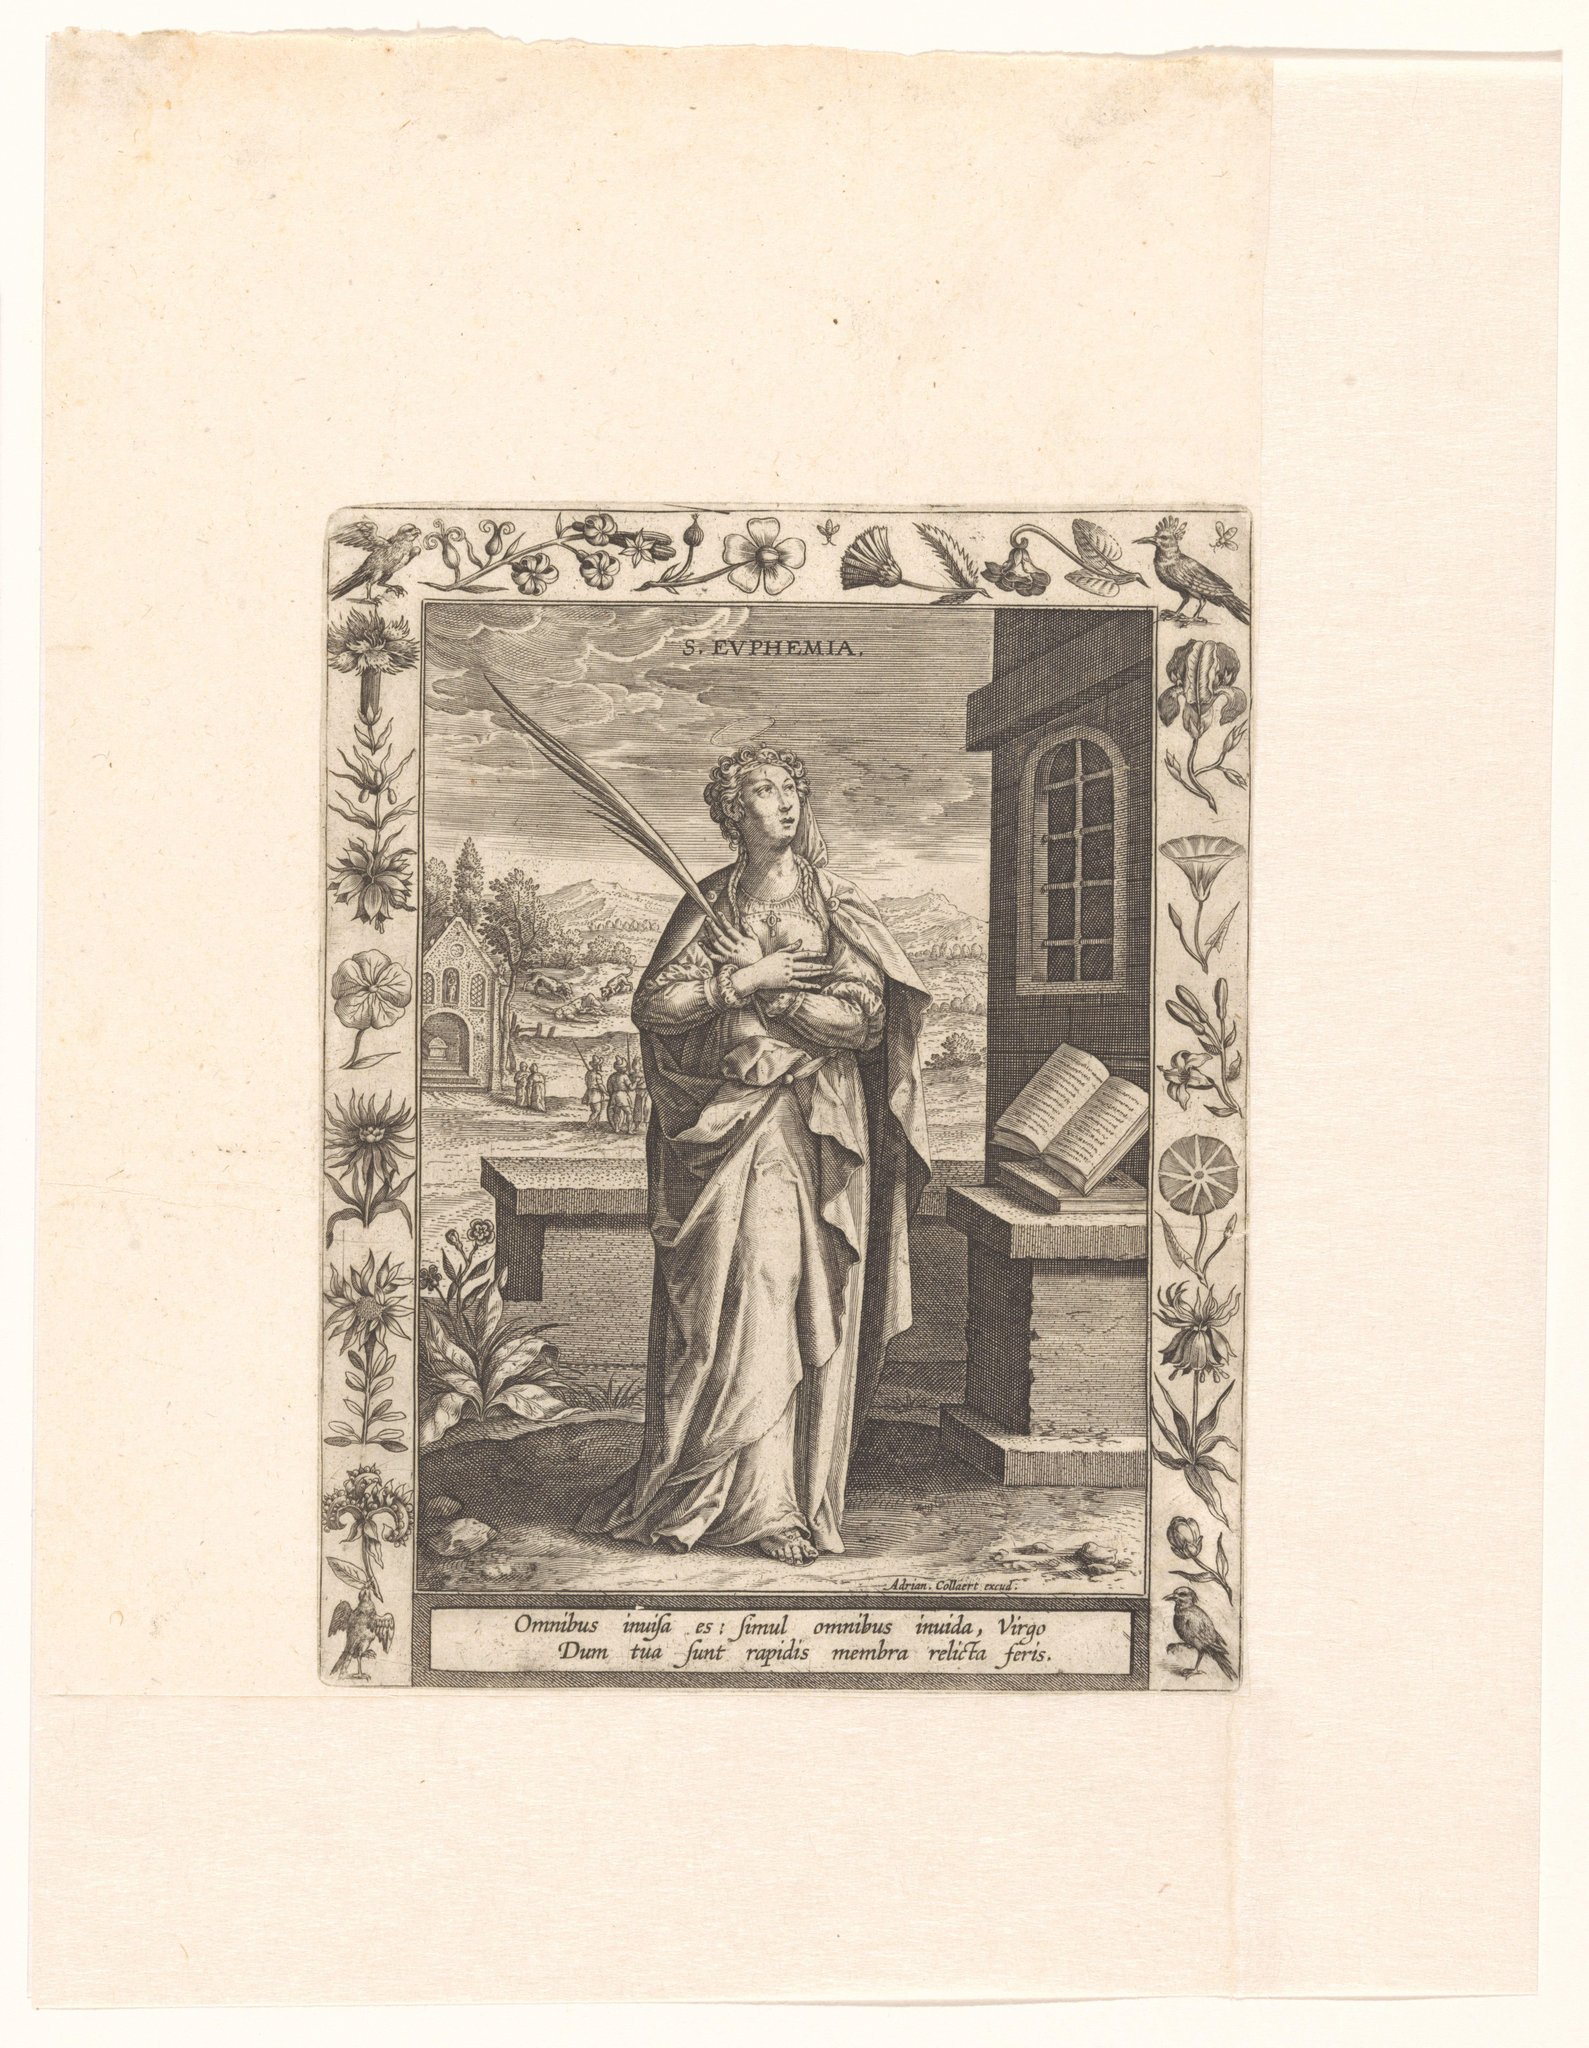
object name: print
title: Heilige Euphemia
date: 1590-1610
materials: paper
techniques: engraving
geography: antwerp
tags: flowers, birds, female saints (with name)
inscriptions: collector's mark: Lugt 2228, collector's mark: Lugt 3751, collector's mark: Lugt 2760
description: Heilige Euphemia. Onderdeel van een serie van 24 voorstellingen van vrouwelijke martelaren (martyrologium). De voorstellingen zijn voorzien van randen met bloemen en dieren.